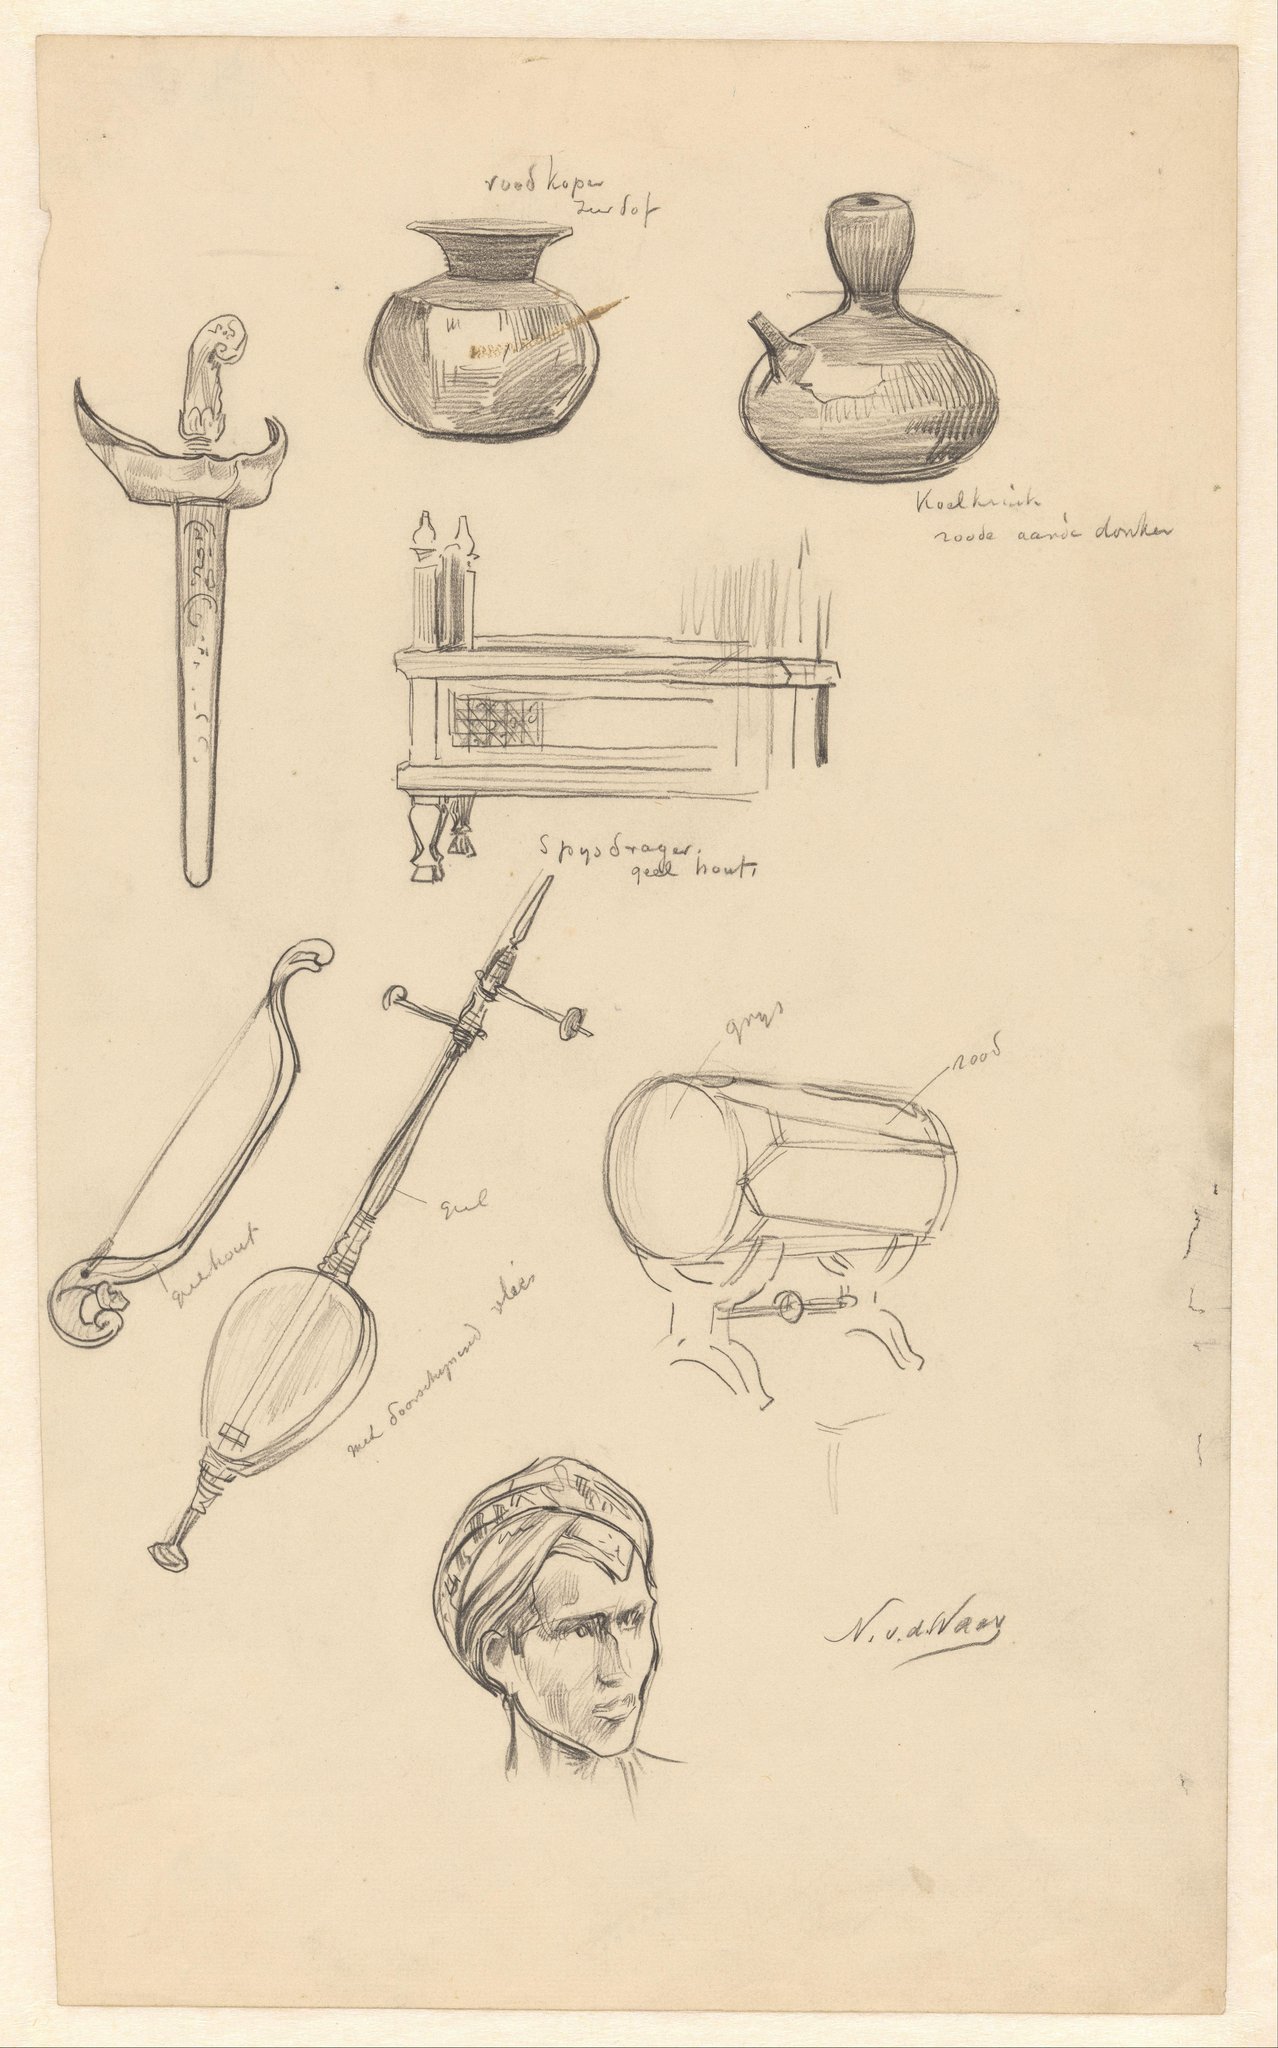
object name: drawing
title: Studieblad met muziekinstrumenten, een kris, kruiken en een kop van een man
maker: nicolaas van der waay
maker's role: draughtsman, painter, print maker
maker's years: 1855-1936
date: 1865-1936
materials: chalk, paper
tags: asiatic races and peoples (indonesians), musical instruments; group of musical instruments, hacking and thrusting weapons, container of ceramics: jar, jug, pot, vase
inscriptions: :, number: ‘973’, collector's mark: Lugt 2228, annotation: ‘spijsdrager/ geel hout.’, annotation: ‘AJ [...]7/30’, collector's mark: Lugt 2760